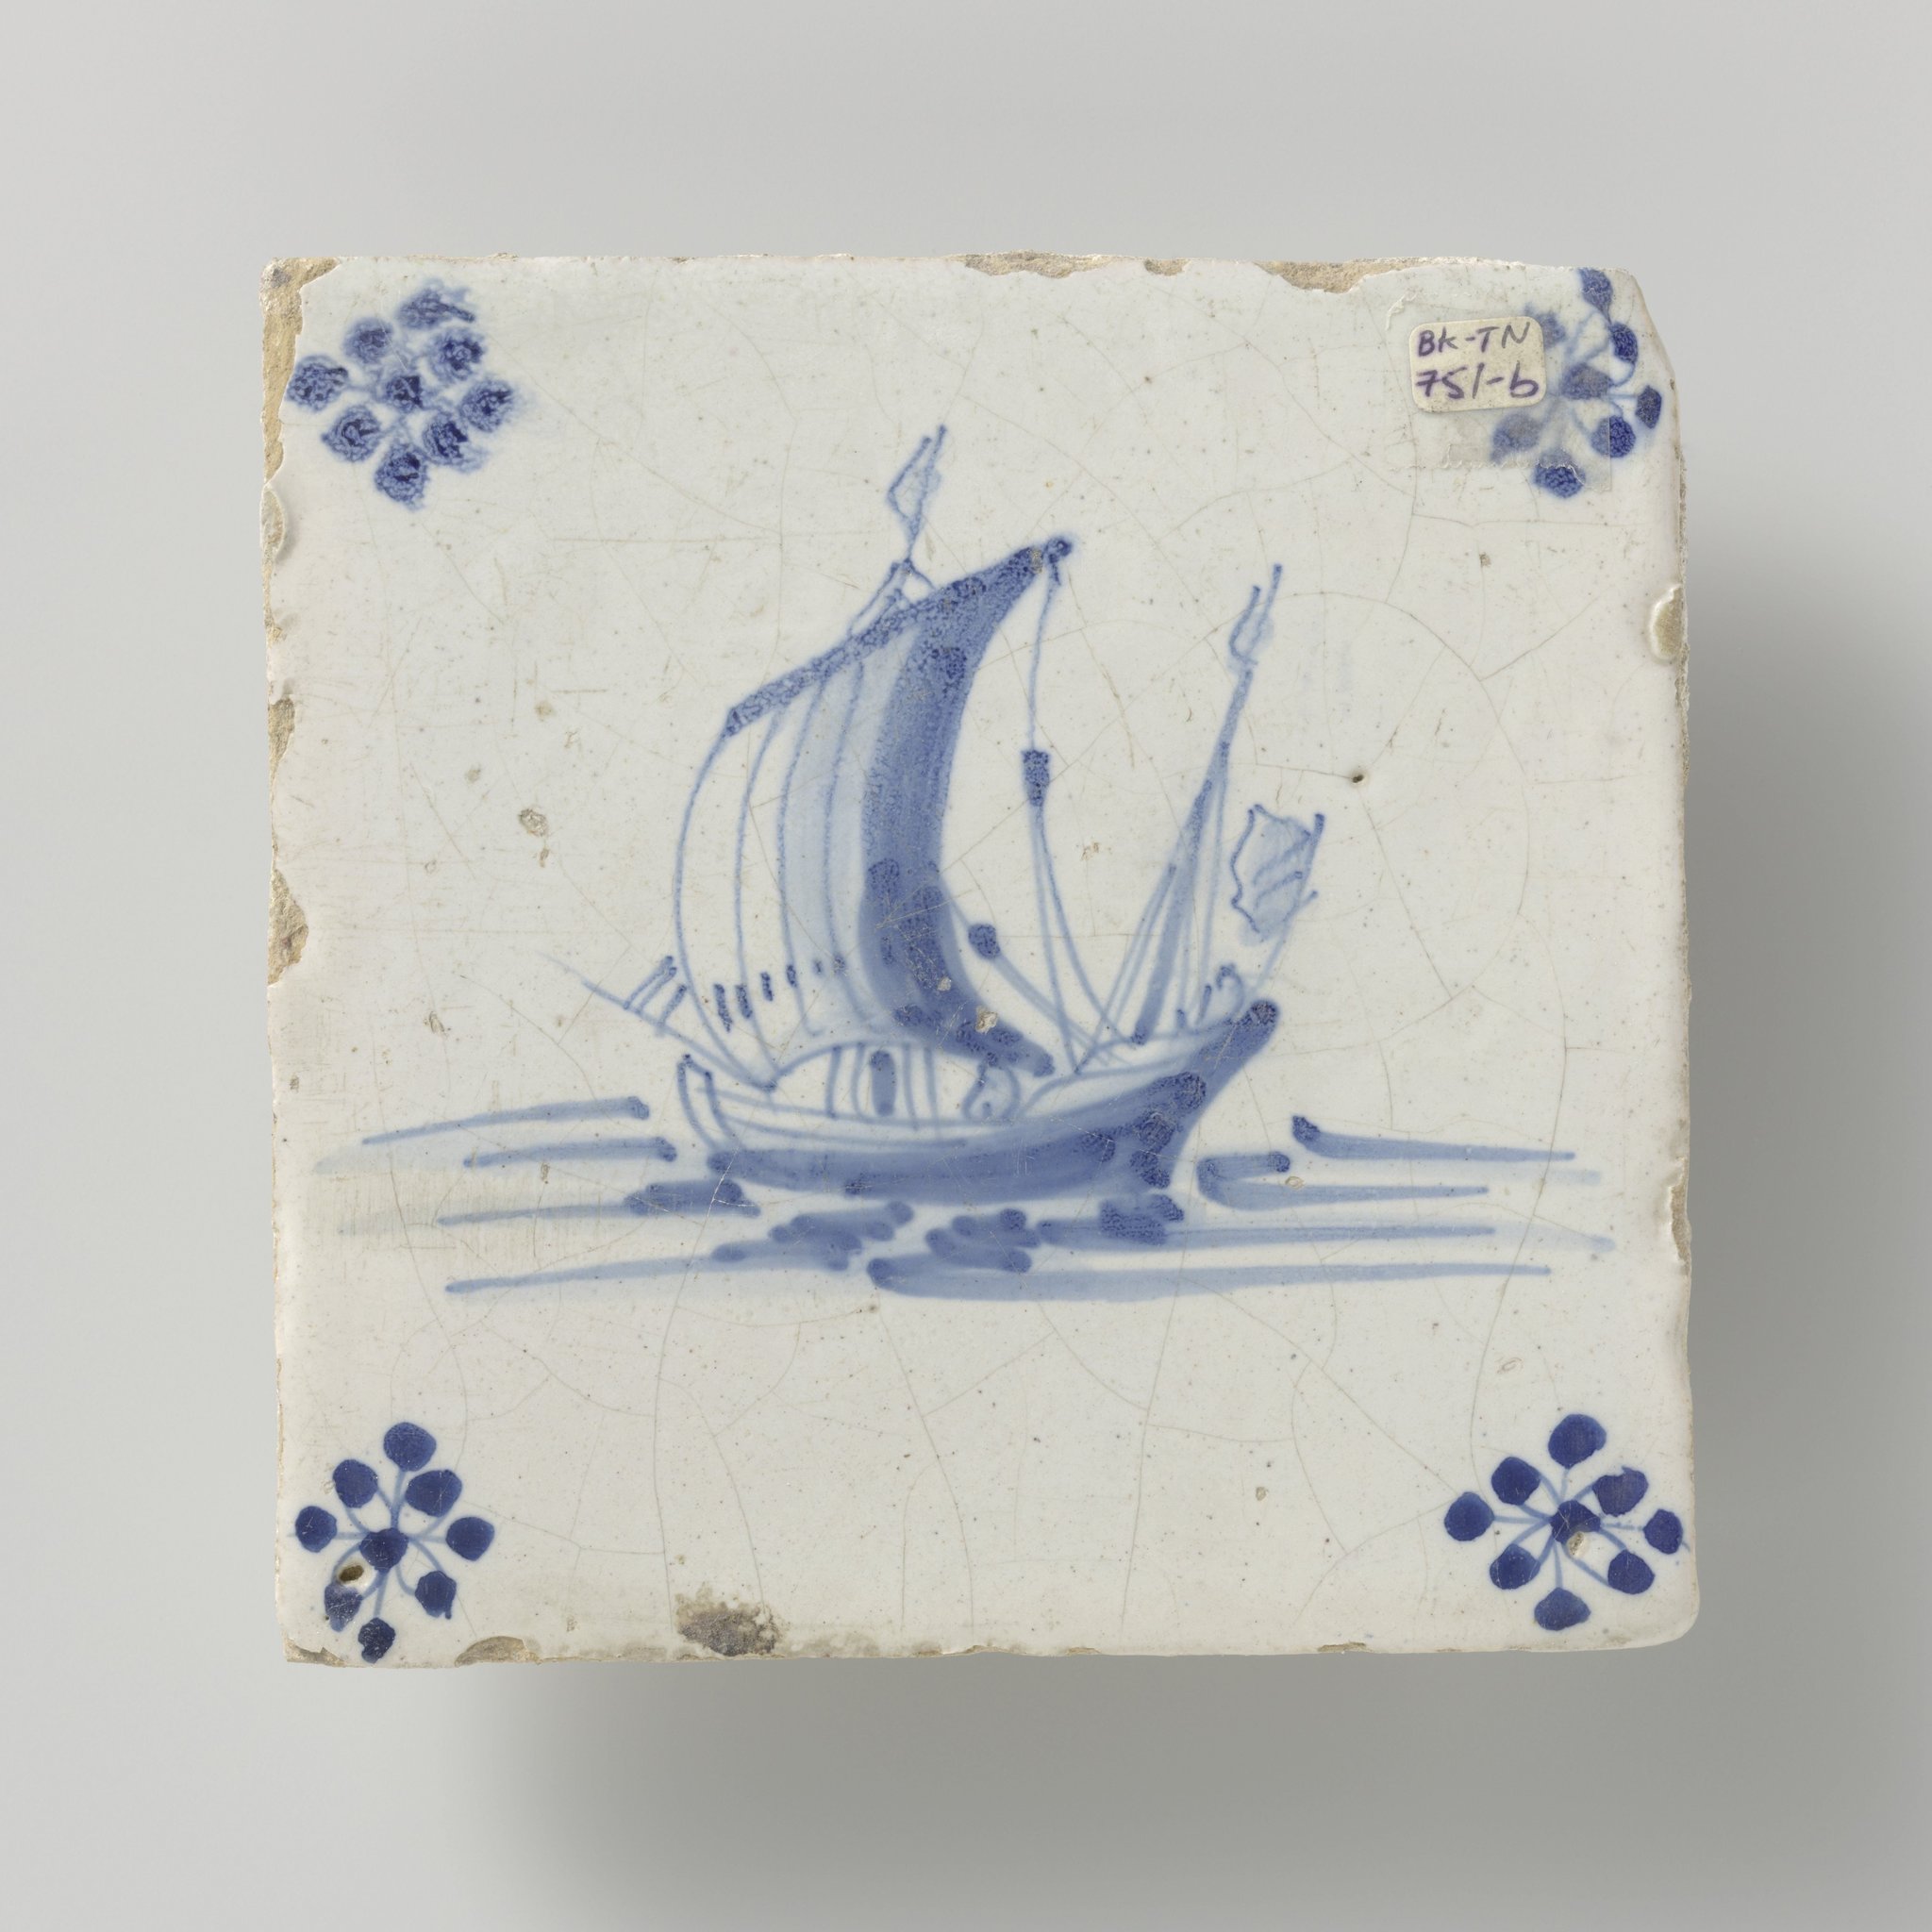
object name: tile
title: Tegel, blauw beschilderd met een schip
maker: Anonymous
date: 1650-1680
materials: earthenware, glaze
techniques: maiolica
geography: netherlands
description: Tegel, blauw beschilderd met een schip, zogenaamd boerenscheepje. In de hoeken een spinnekop.